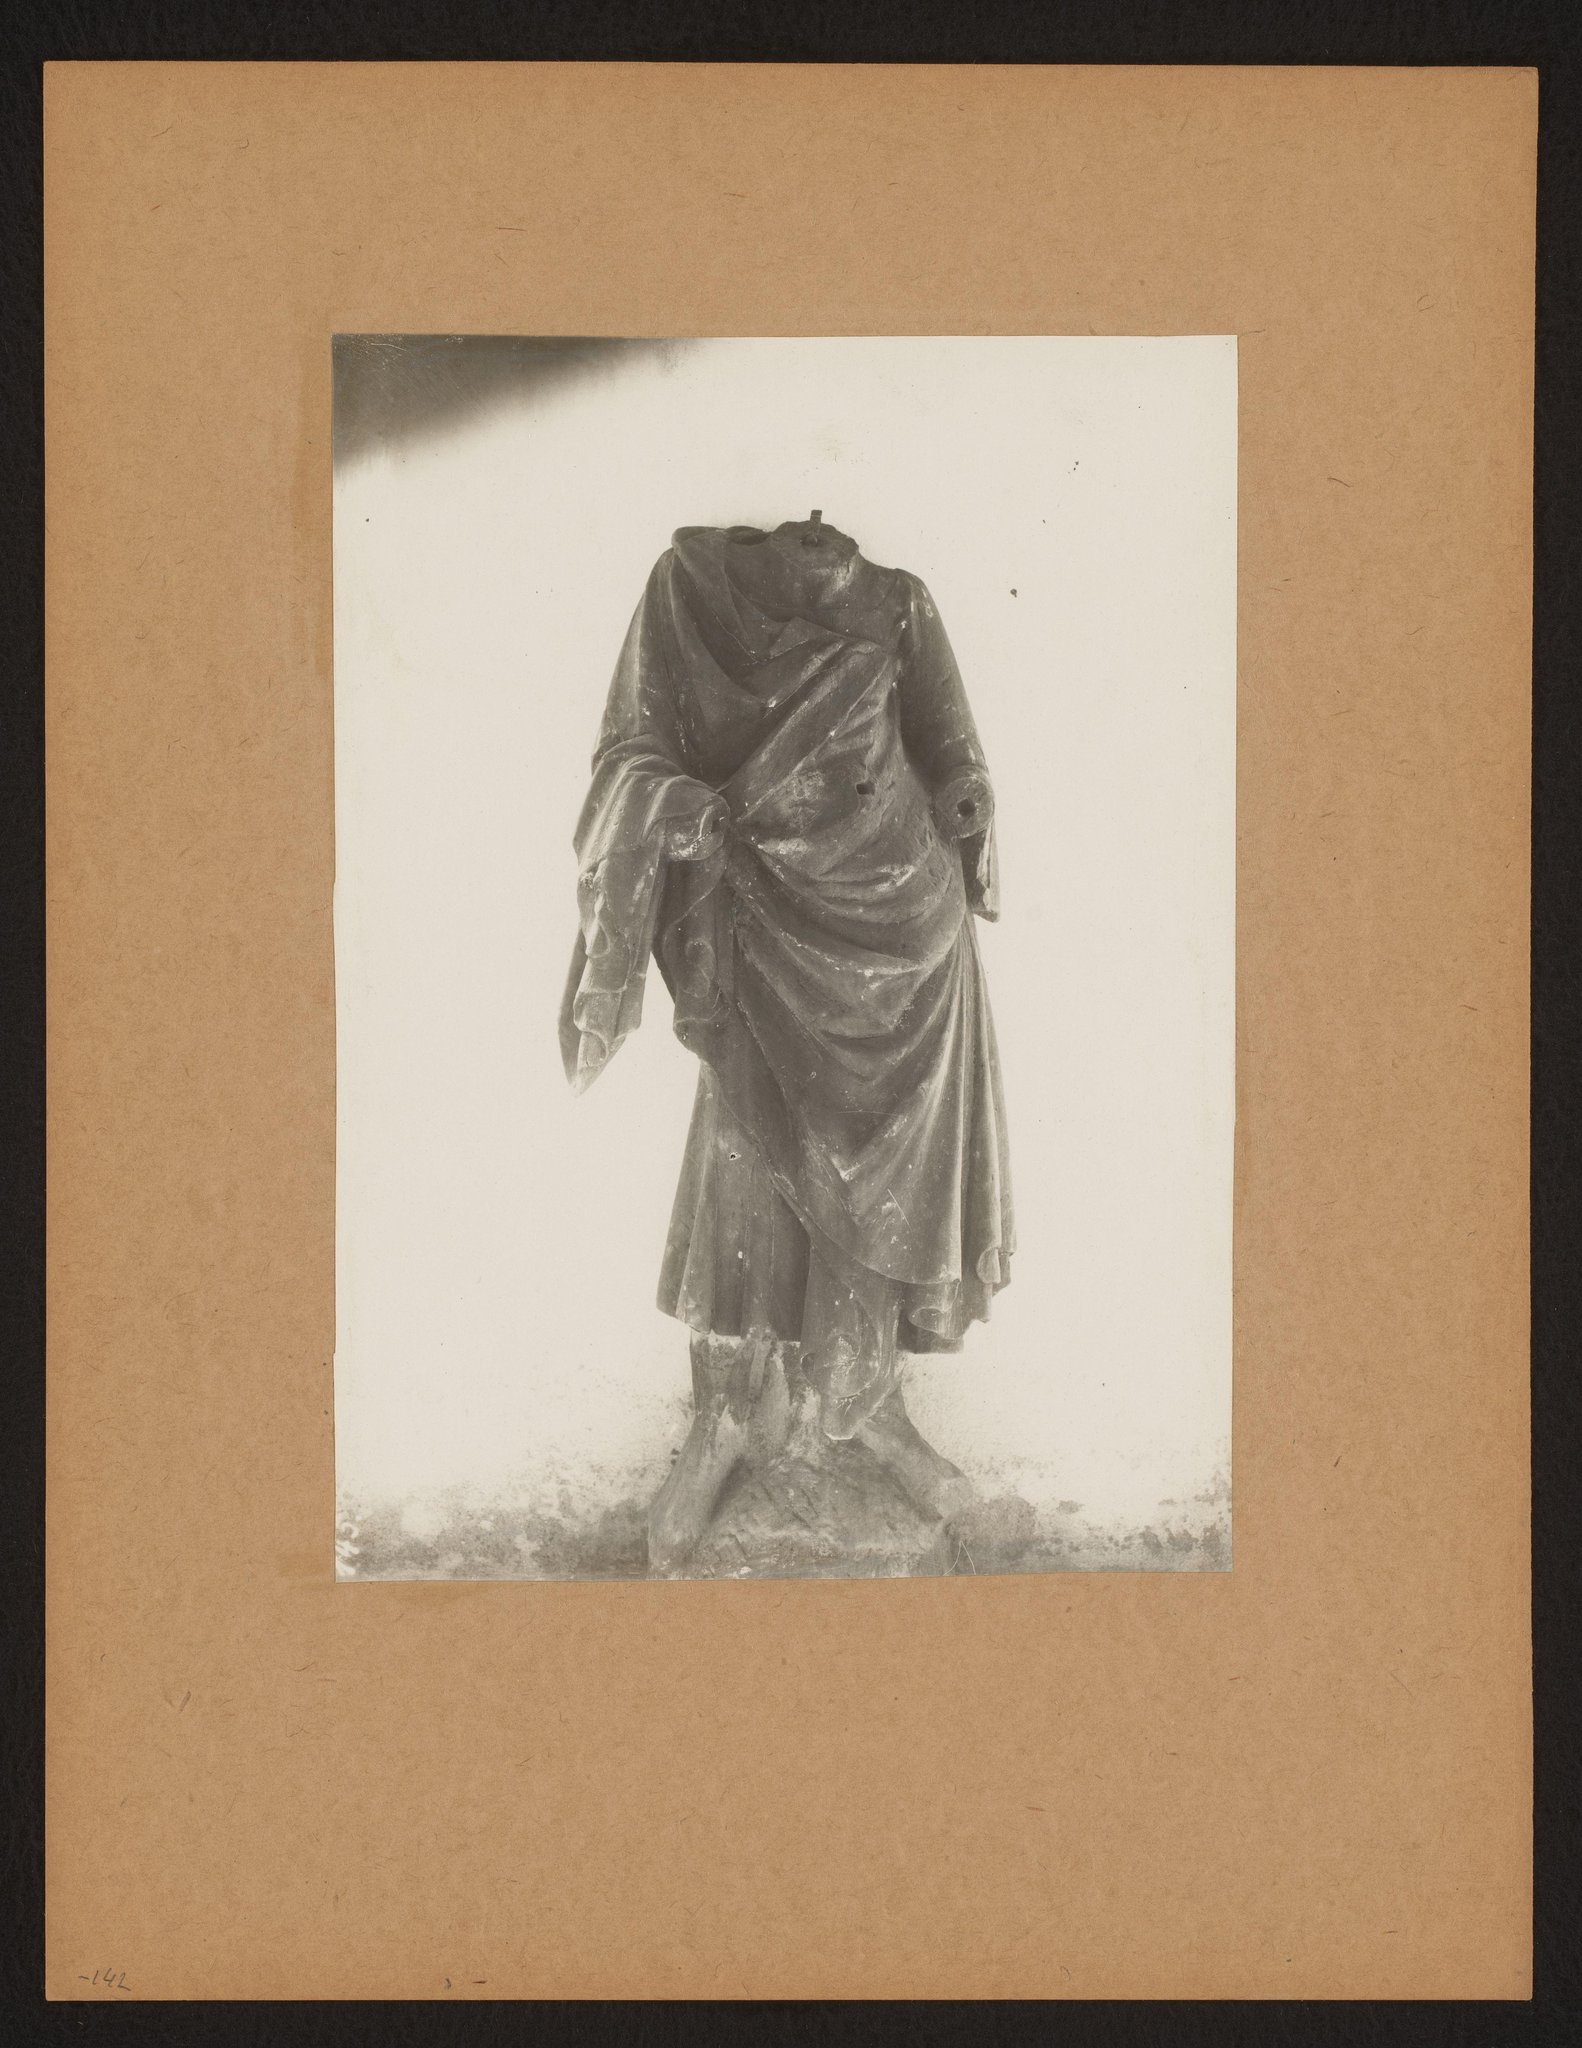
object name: photograph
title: Kreuzgang, männl. Toros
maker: Anonymous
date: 1900-1920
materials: paper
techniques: gelatin silver print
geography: bamberg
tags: interior of church